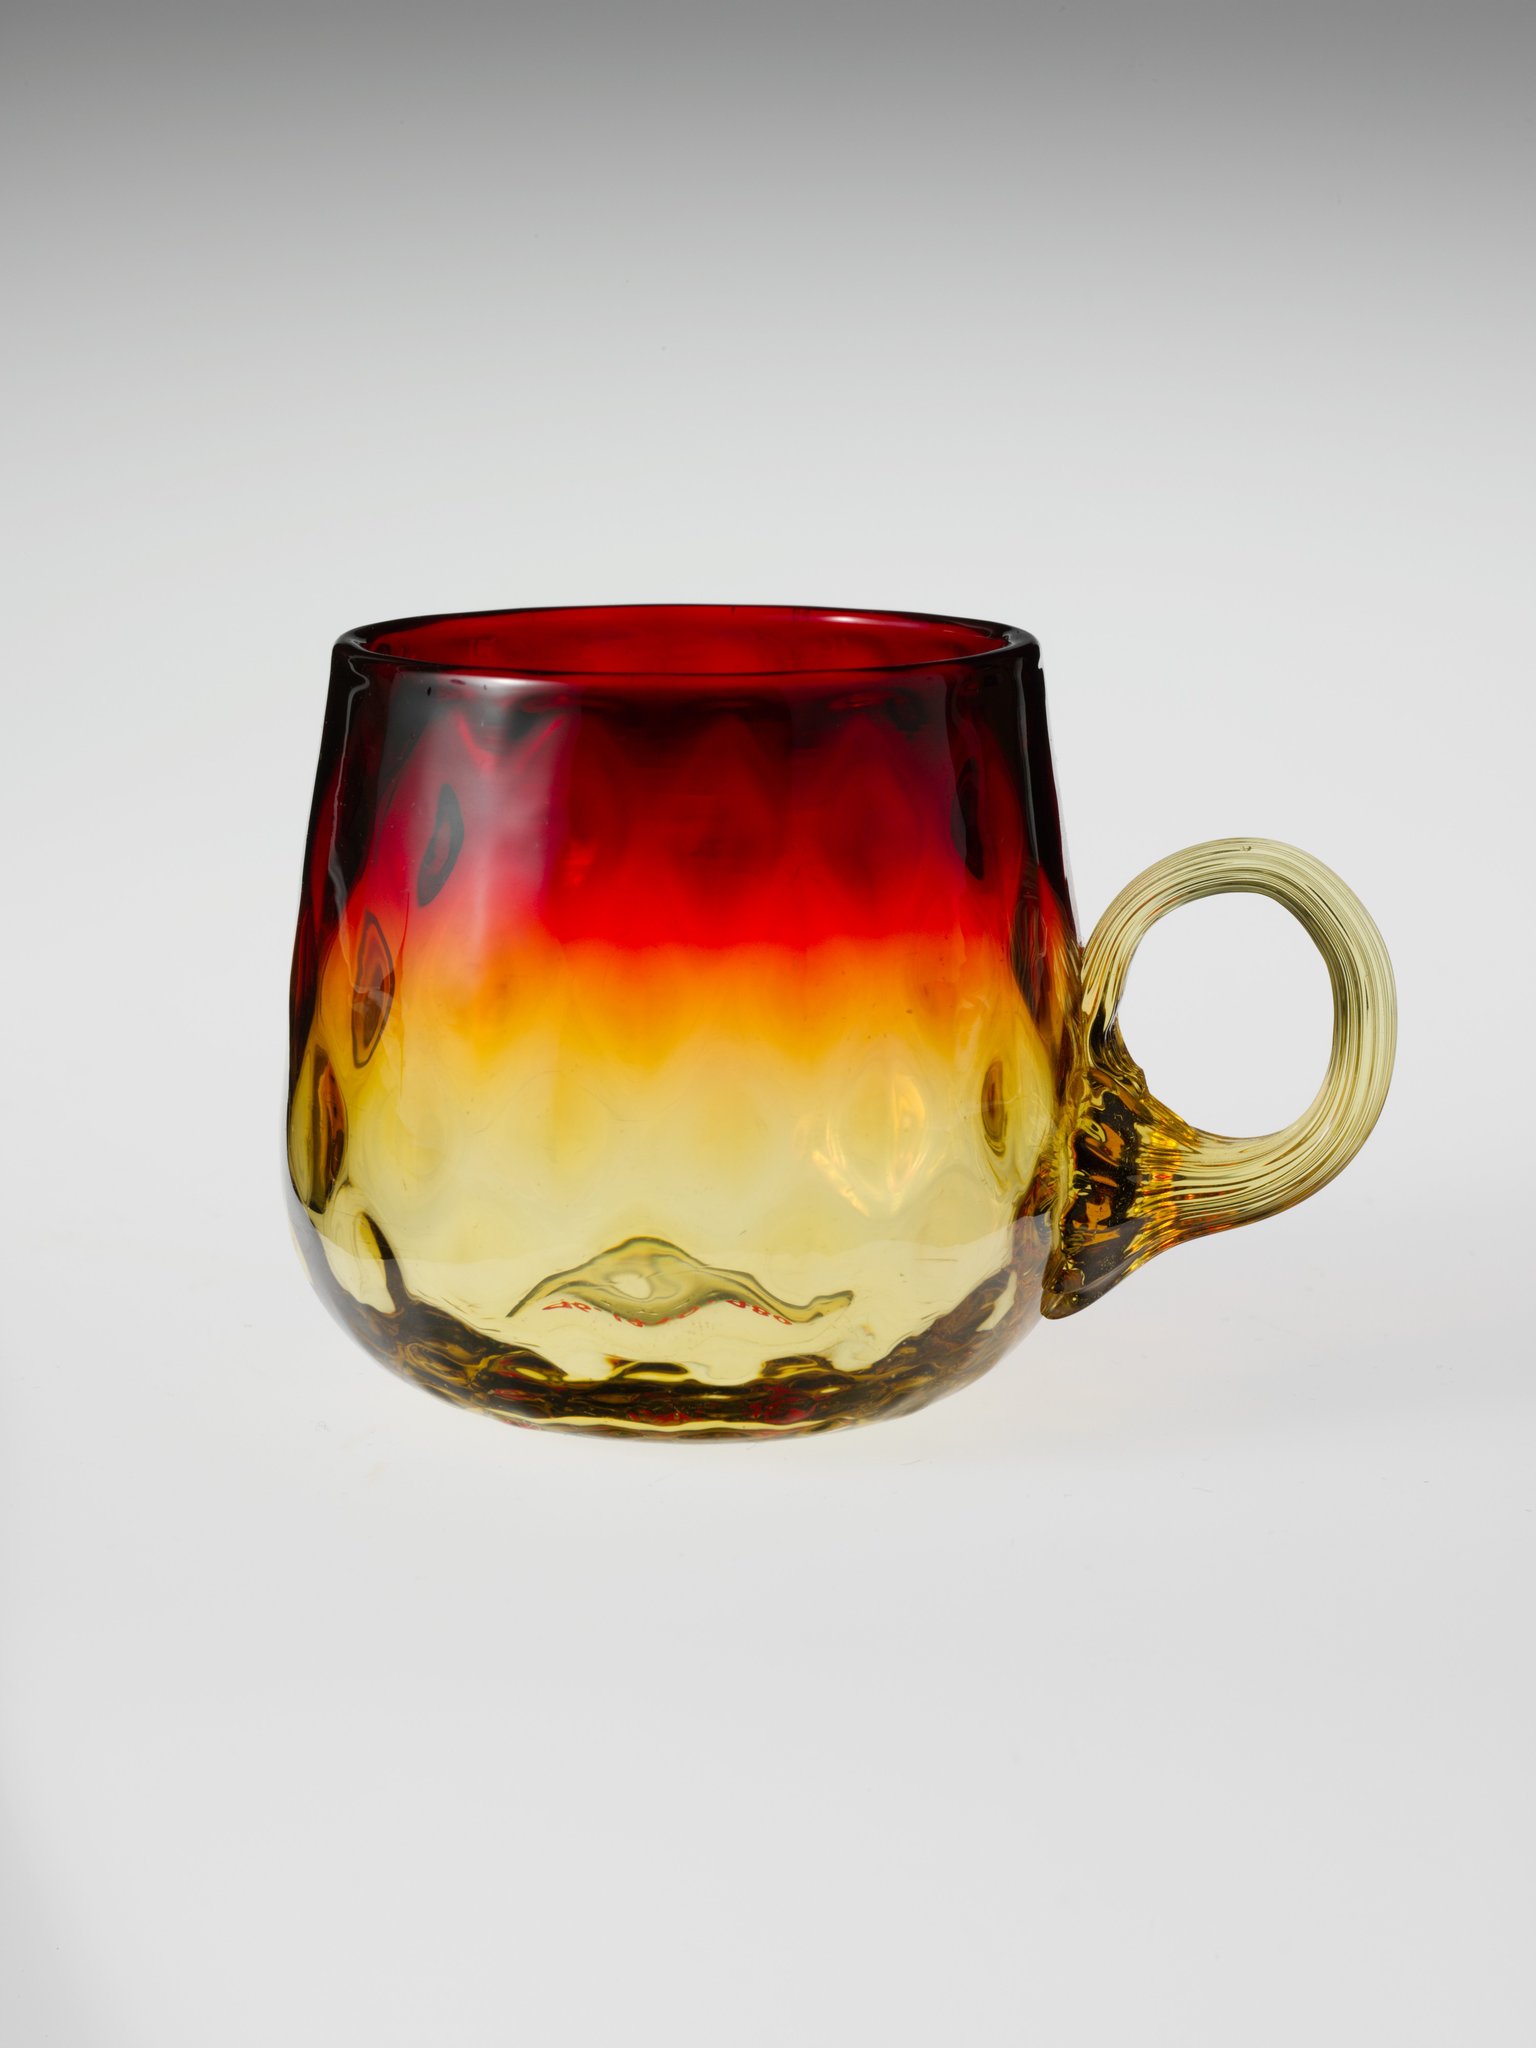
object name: cup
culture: american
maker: new england glass company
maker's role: maker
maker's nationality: american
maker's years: 1818-1888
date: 1801-1900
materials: glass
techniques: glassblowing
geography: united states